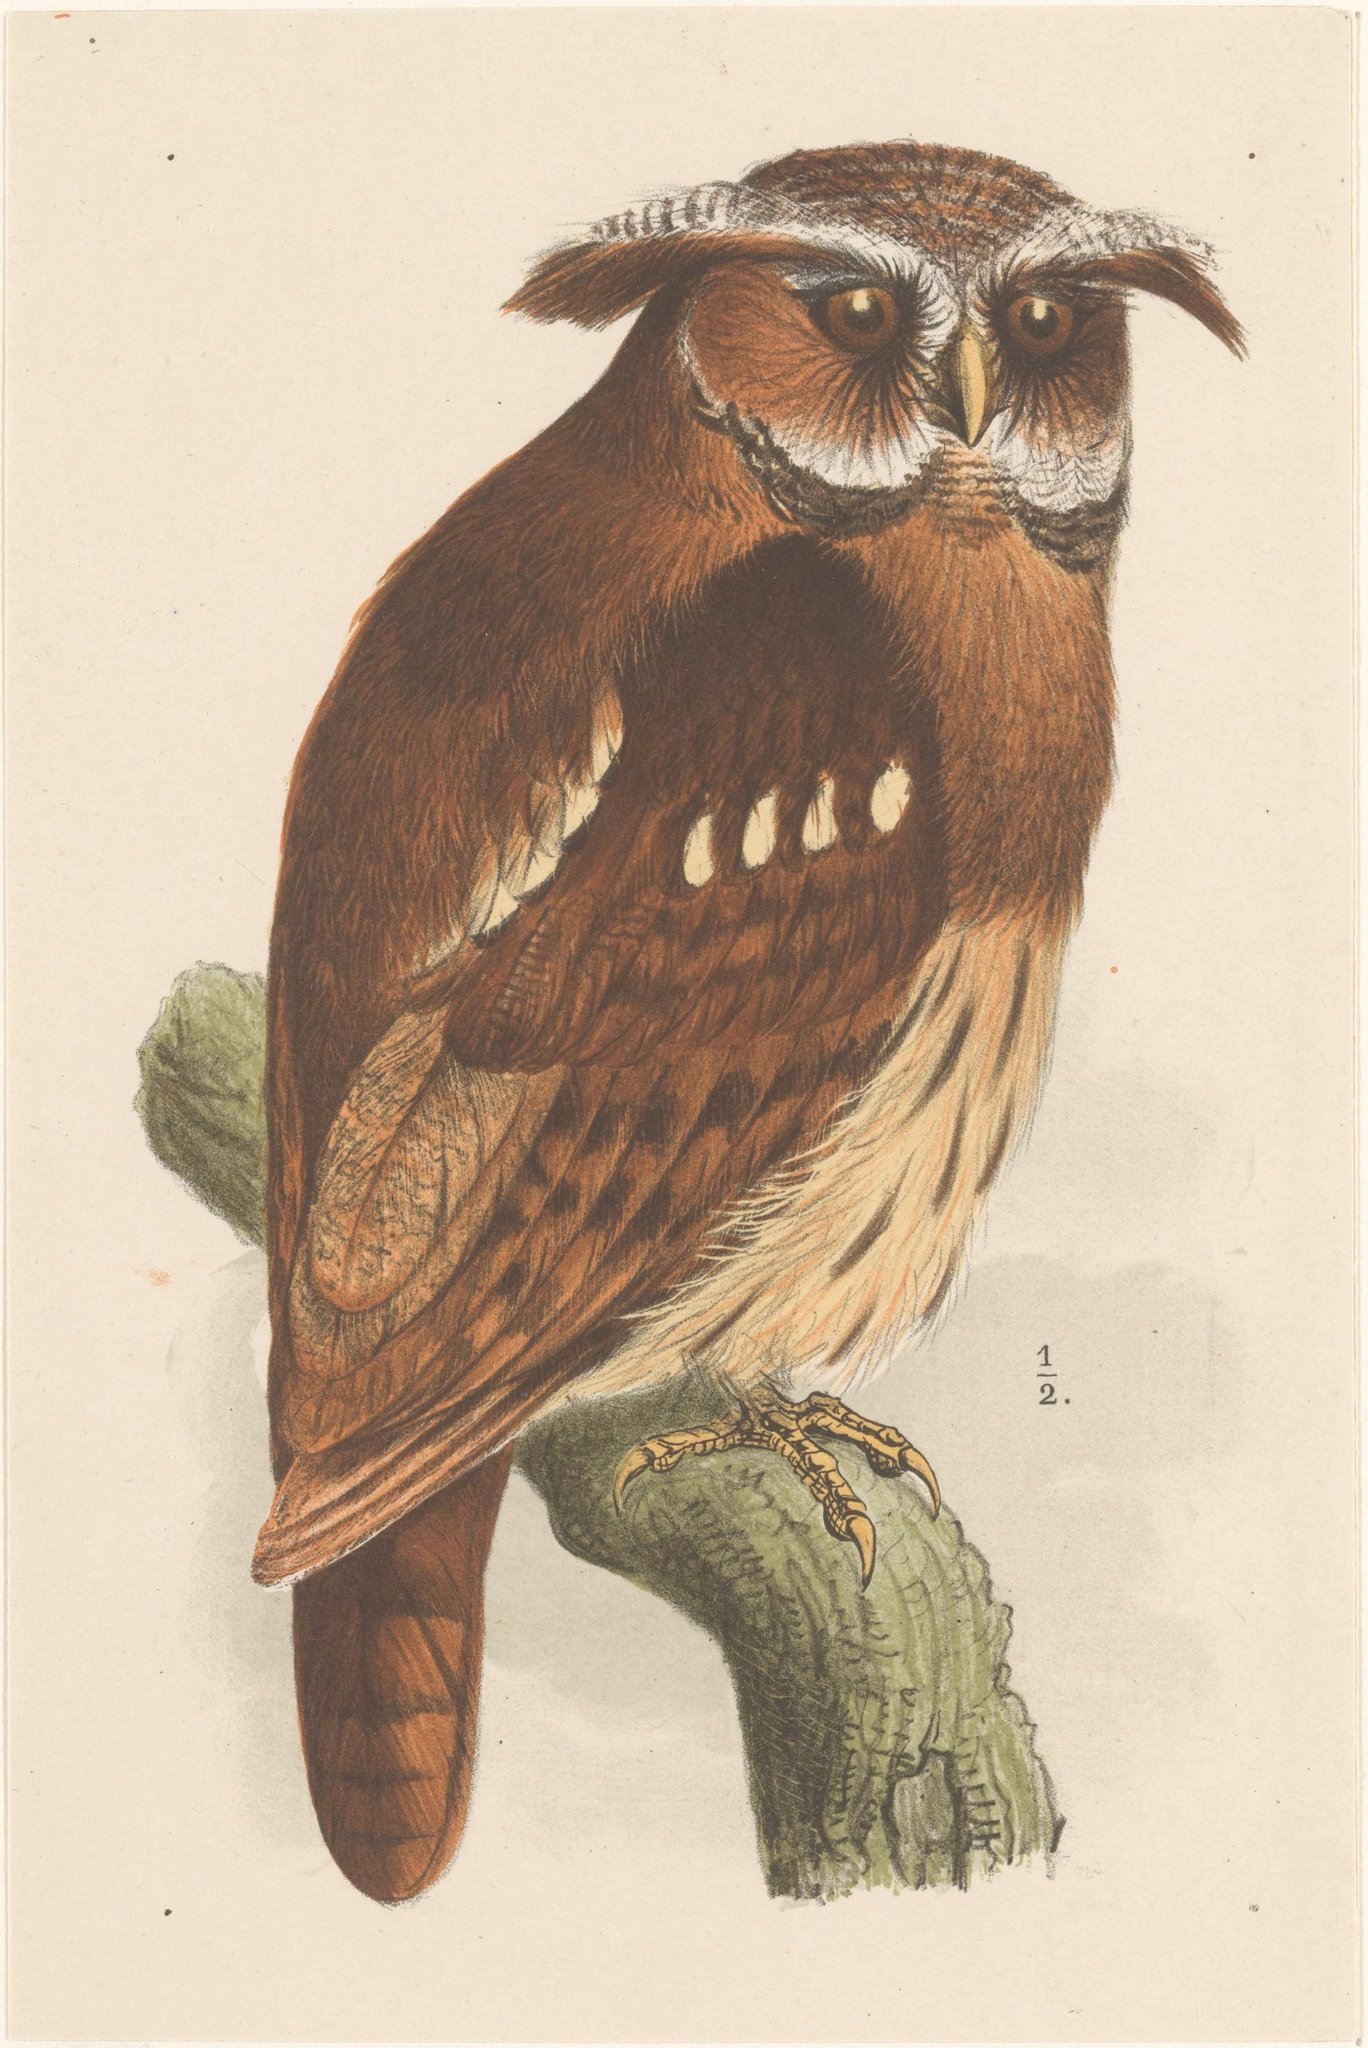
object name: illustration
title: Uil op een tak (bubo lettii)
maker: theo van hoytema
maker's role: draughtsman, painter, print maker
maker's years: 1863-1917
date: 1878-1889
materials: paper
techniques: lithograph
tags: owls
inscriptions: collector's mark: Lugt 2228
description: Prent ook gebruikt voor: J. Büttikofer, 'On a new Owl from Liberia', Notes from the Leyden Museum XI (1889), p. 34 en voor: J. Büttikofer, 'Zoological researches in Liberia. Fourth list of Birds', Notes from the Leyden Museum XI (1889), p. 113-138.